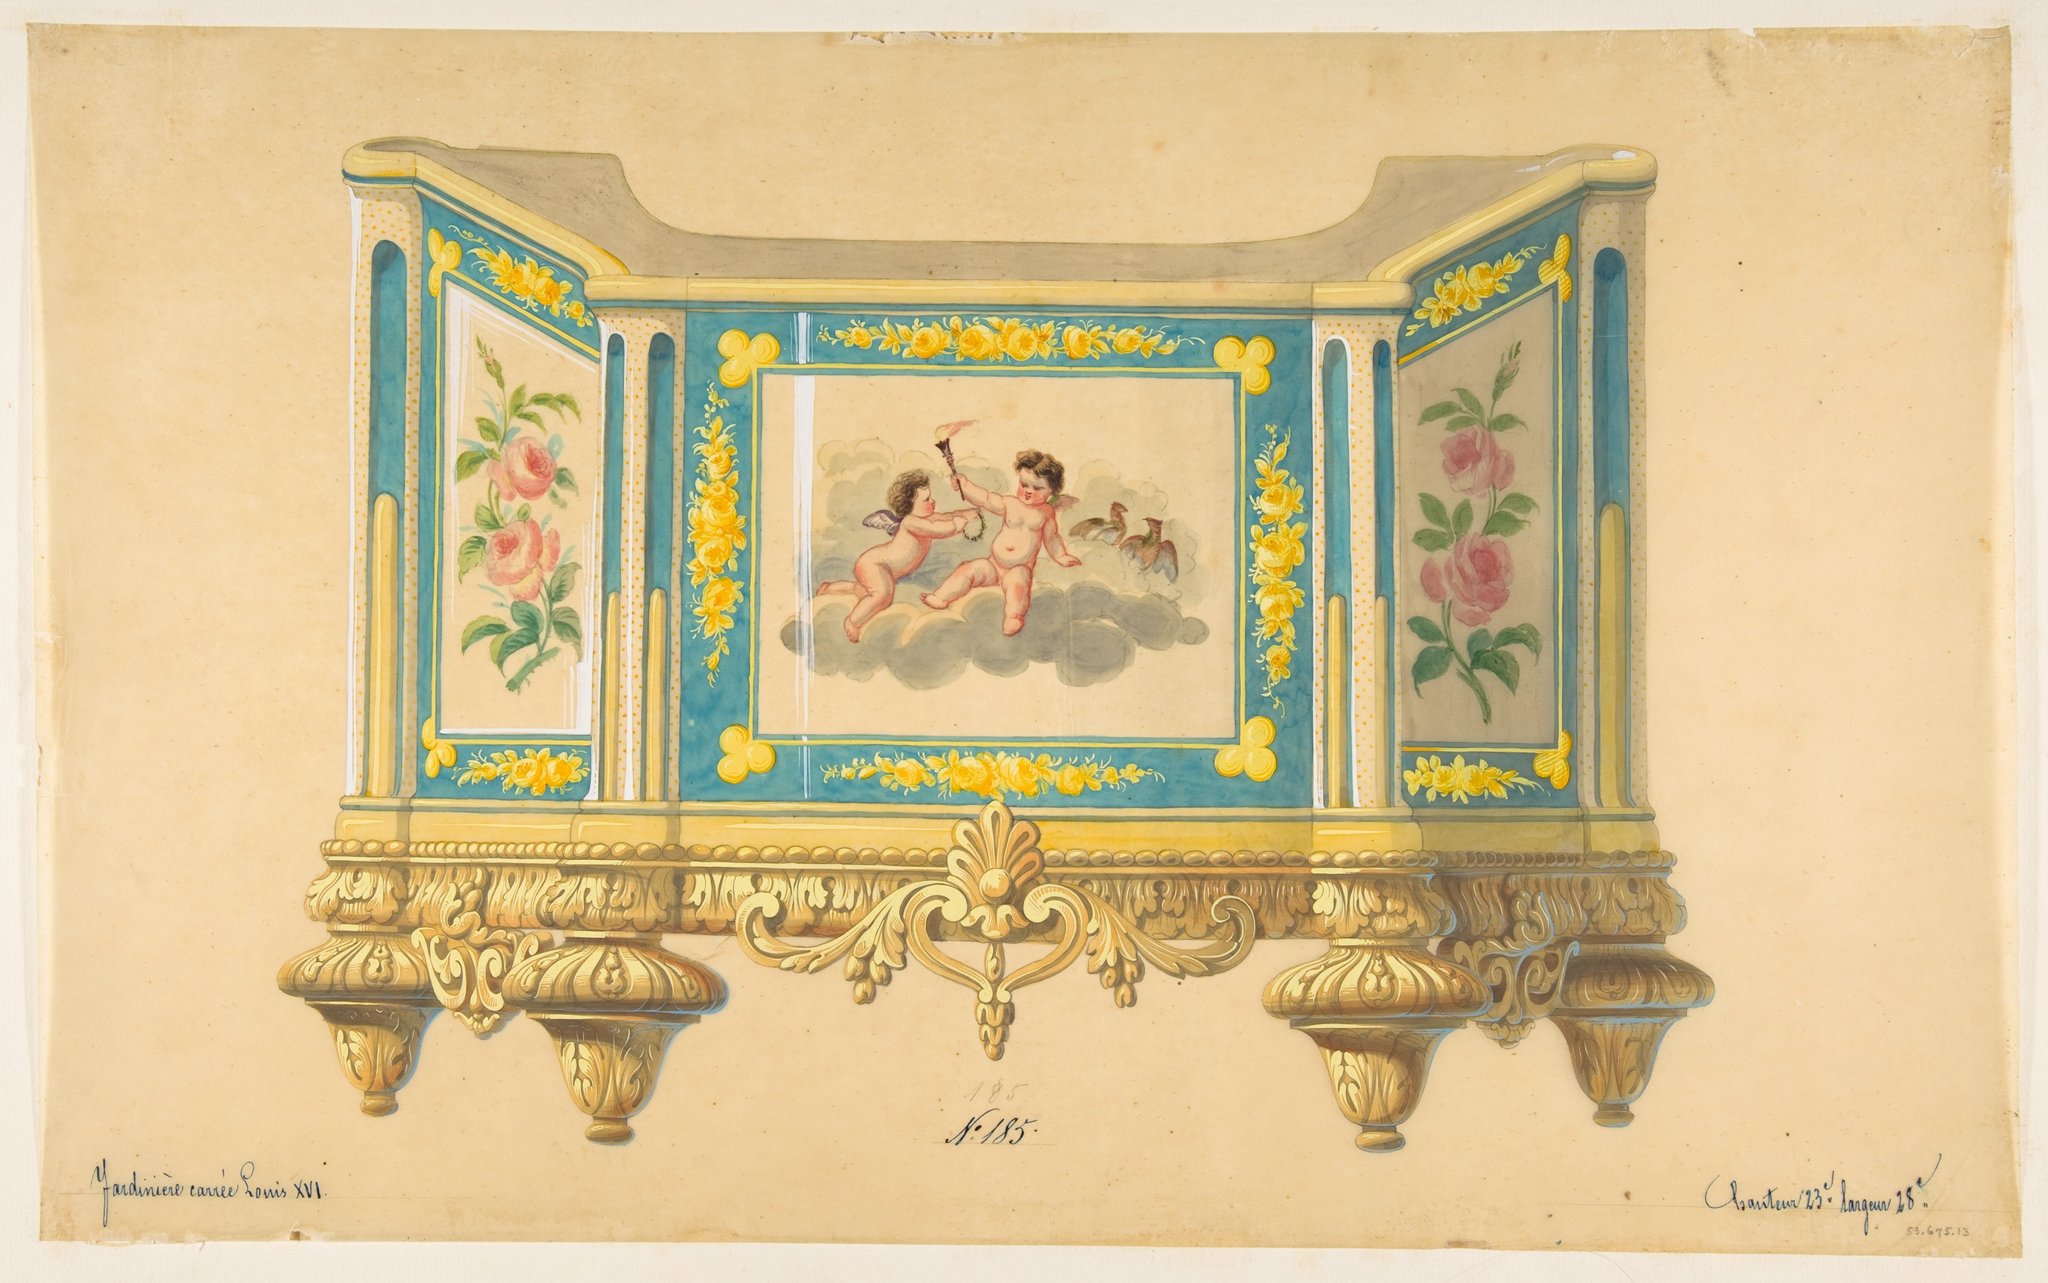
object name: drawing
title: Design for a Jardiniere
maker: anonymous, french, 19th century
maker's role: artist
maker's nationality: french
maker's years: 1800-1900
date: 1801-1900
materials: gouache, graphite, watercolor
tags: flowers